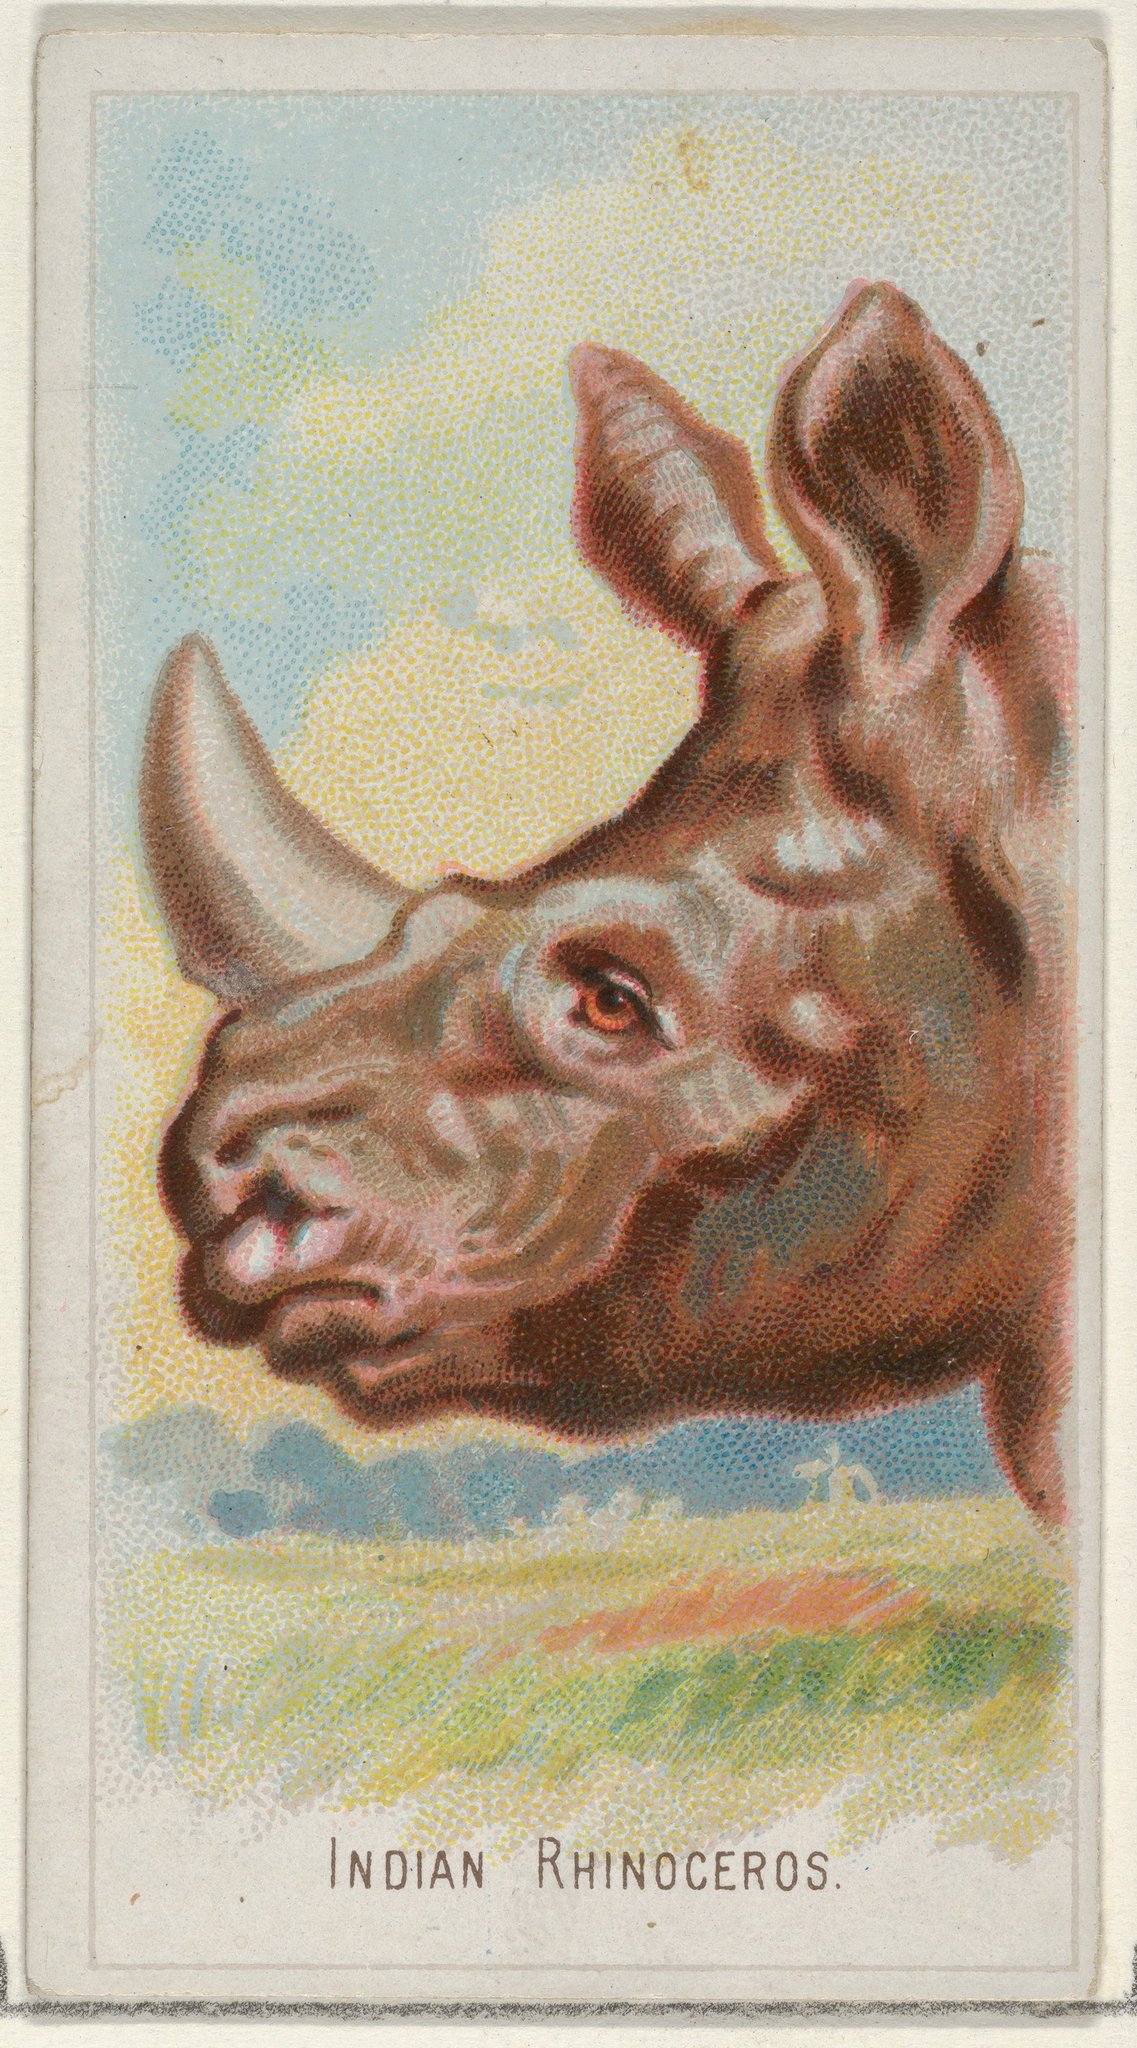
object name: print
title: Indian Rhinoceros, from the Wild Animals of the World series (N25) for Allen & Ginter Cigarettes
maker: allen & ginter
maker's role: publisher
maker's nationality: american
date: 1888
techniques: color lithograph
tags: animals